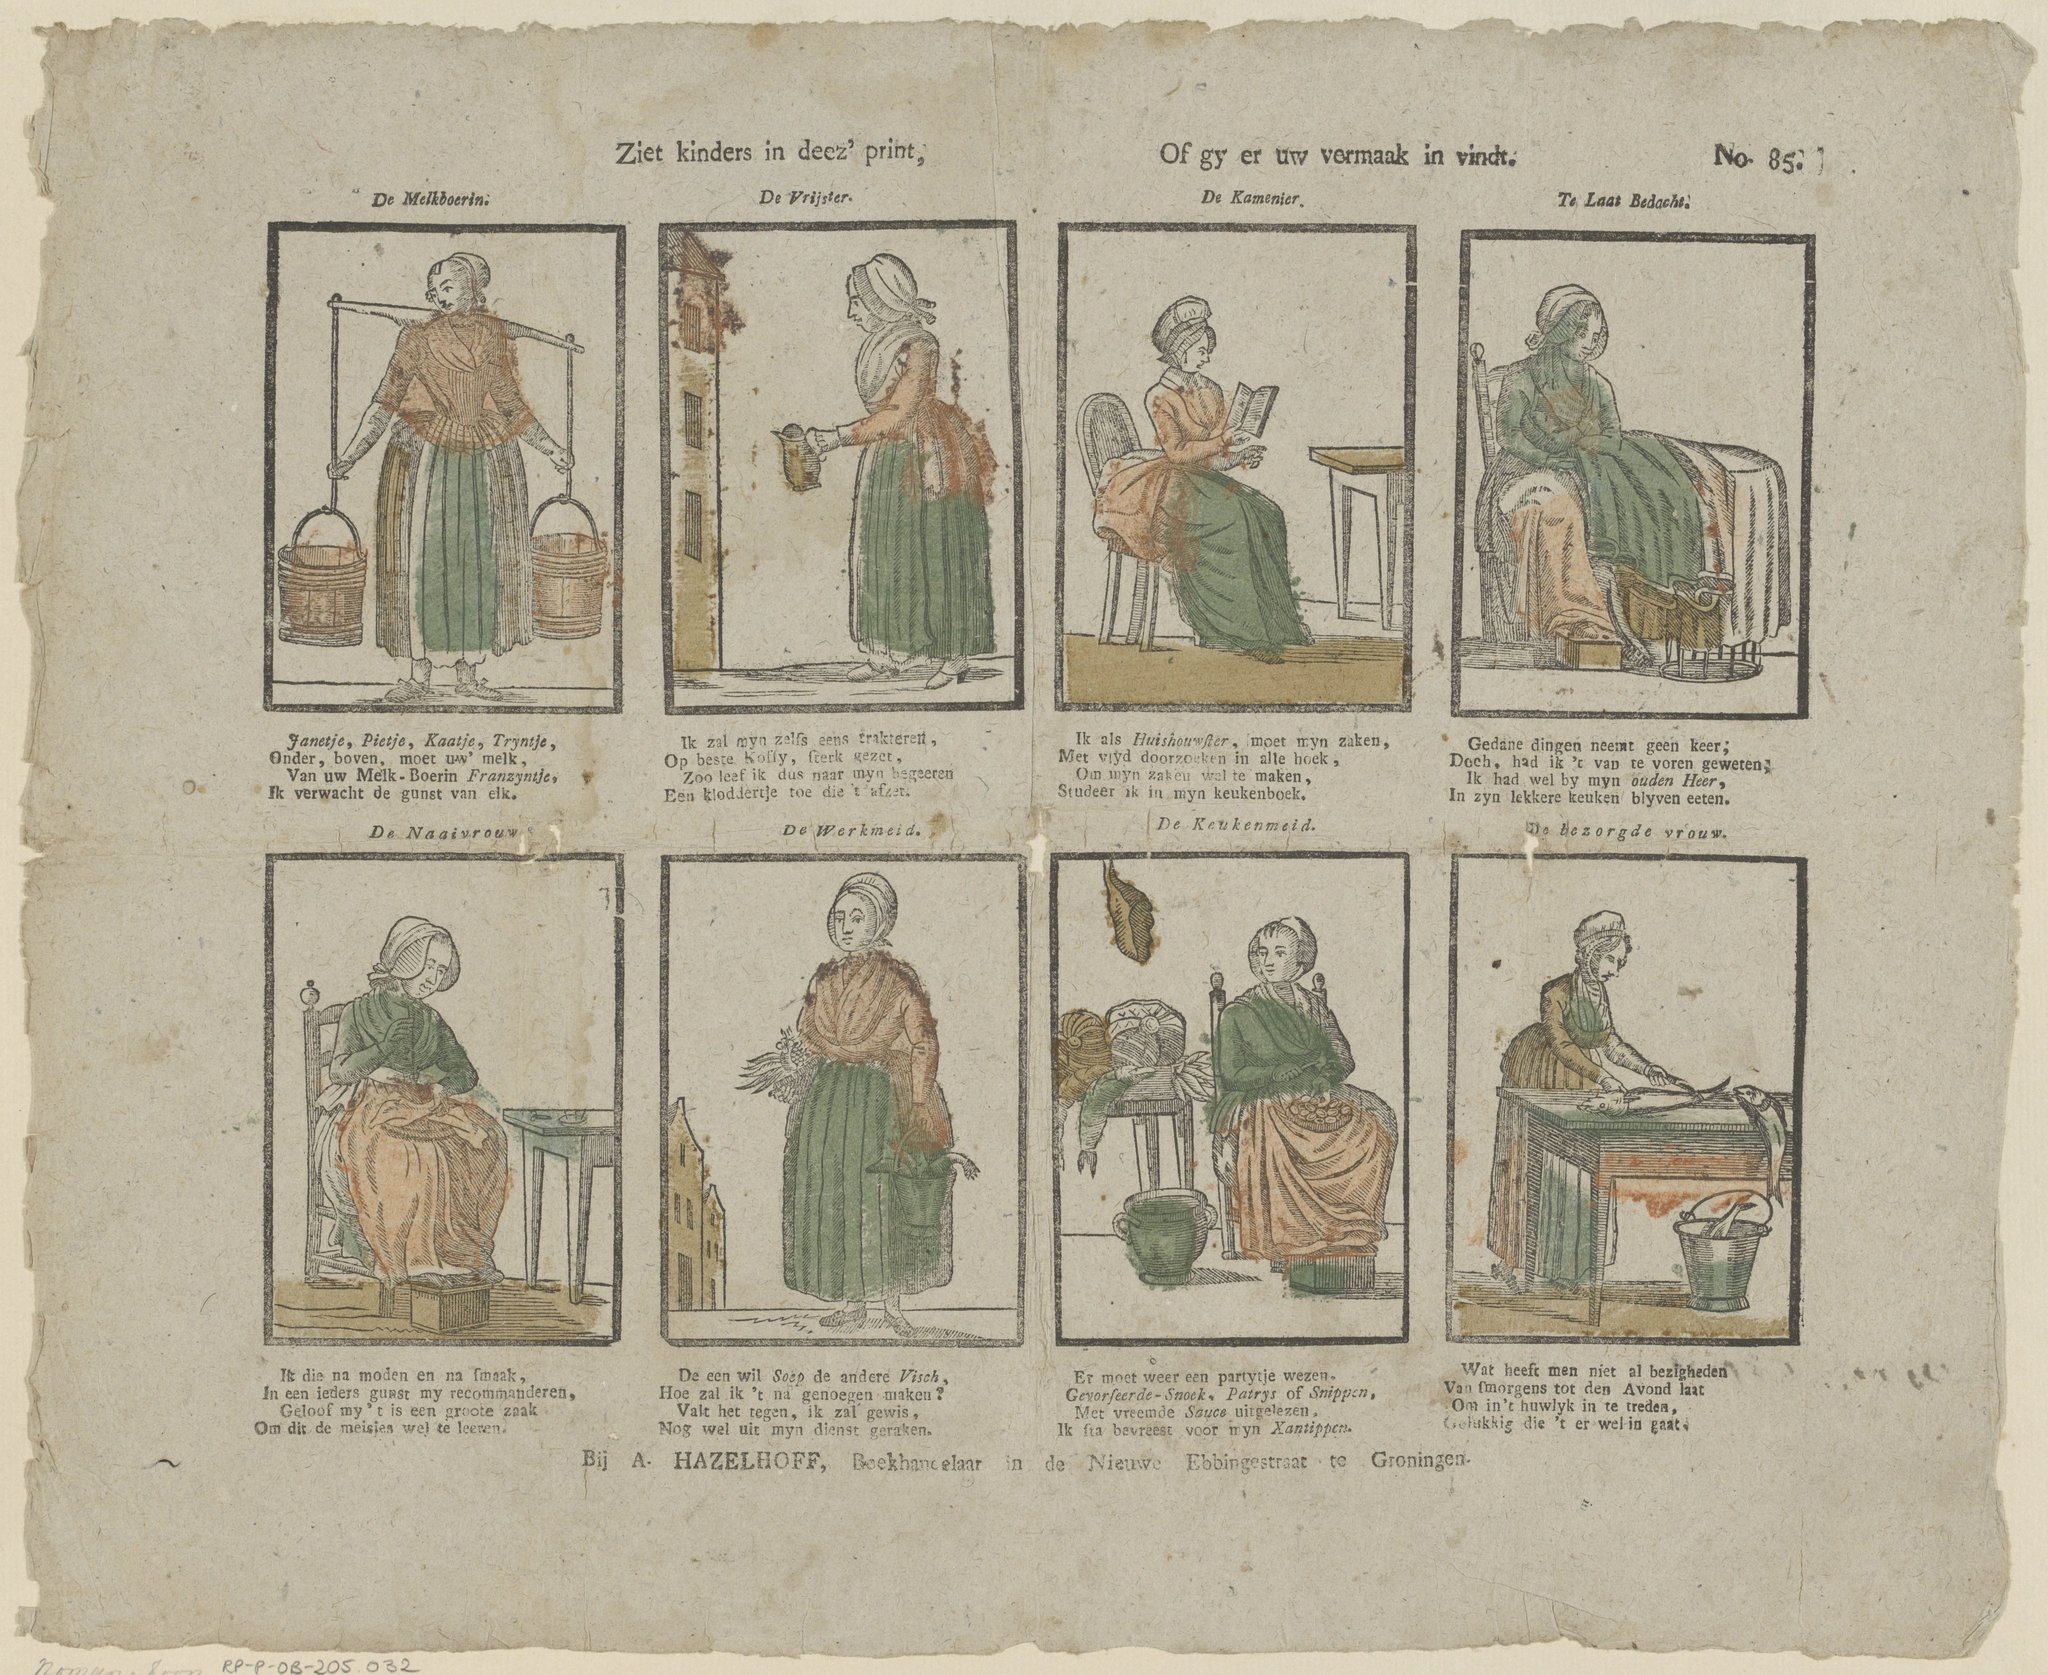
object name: popular print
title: Ziet kinders in deez' print, Of gy er uw vermaak in vindt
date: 1830-1892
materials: paper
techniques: colour, letterpress printing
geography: netherlands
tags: reading, cooking food, household chores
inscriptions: inscription, collector's mark: Lugt 2760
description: Blad met 8 voorstellingen van bezigheden voor vrouwen, zoals koken, lezen en naaien. Onder elke afbeelding een vierregelig vers, boven elke afbeelding een titel. Genummerd rechtsboven: No. 85.